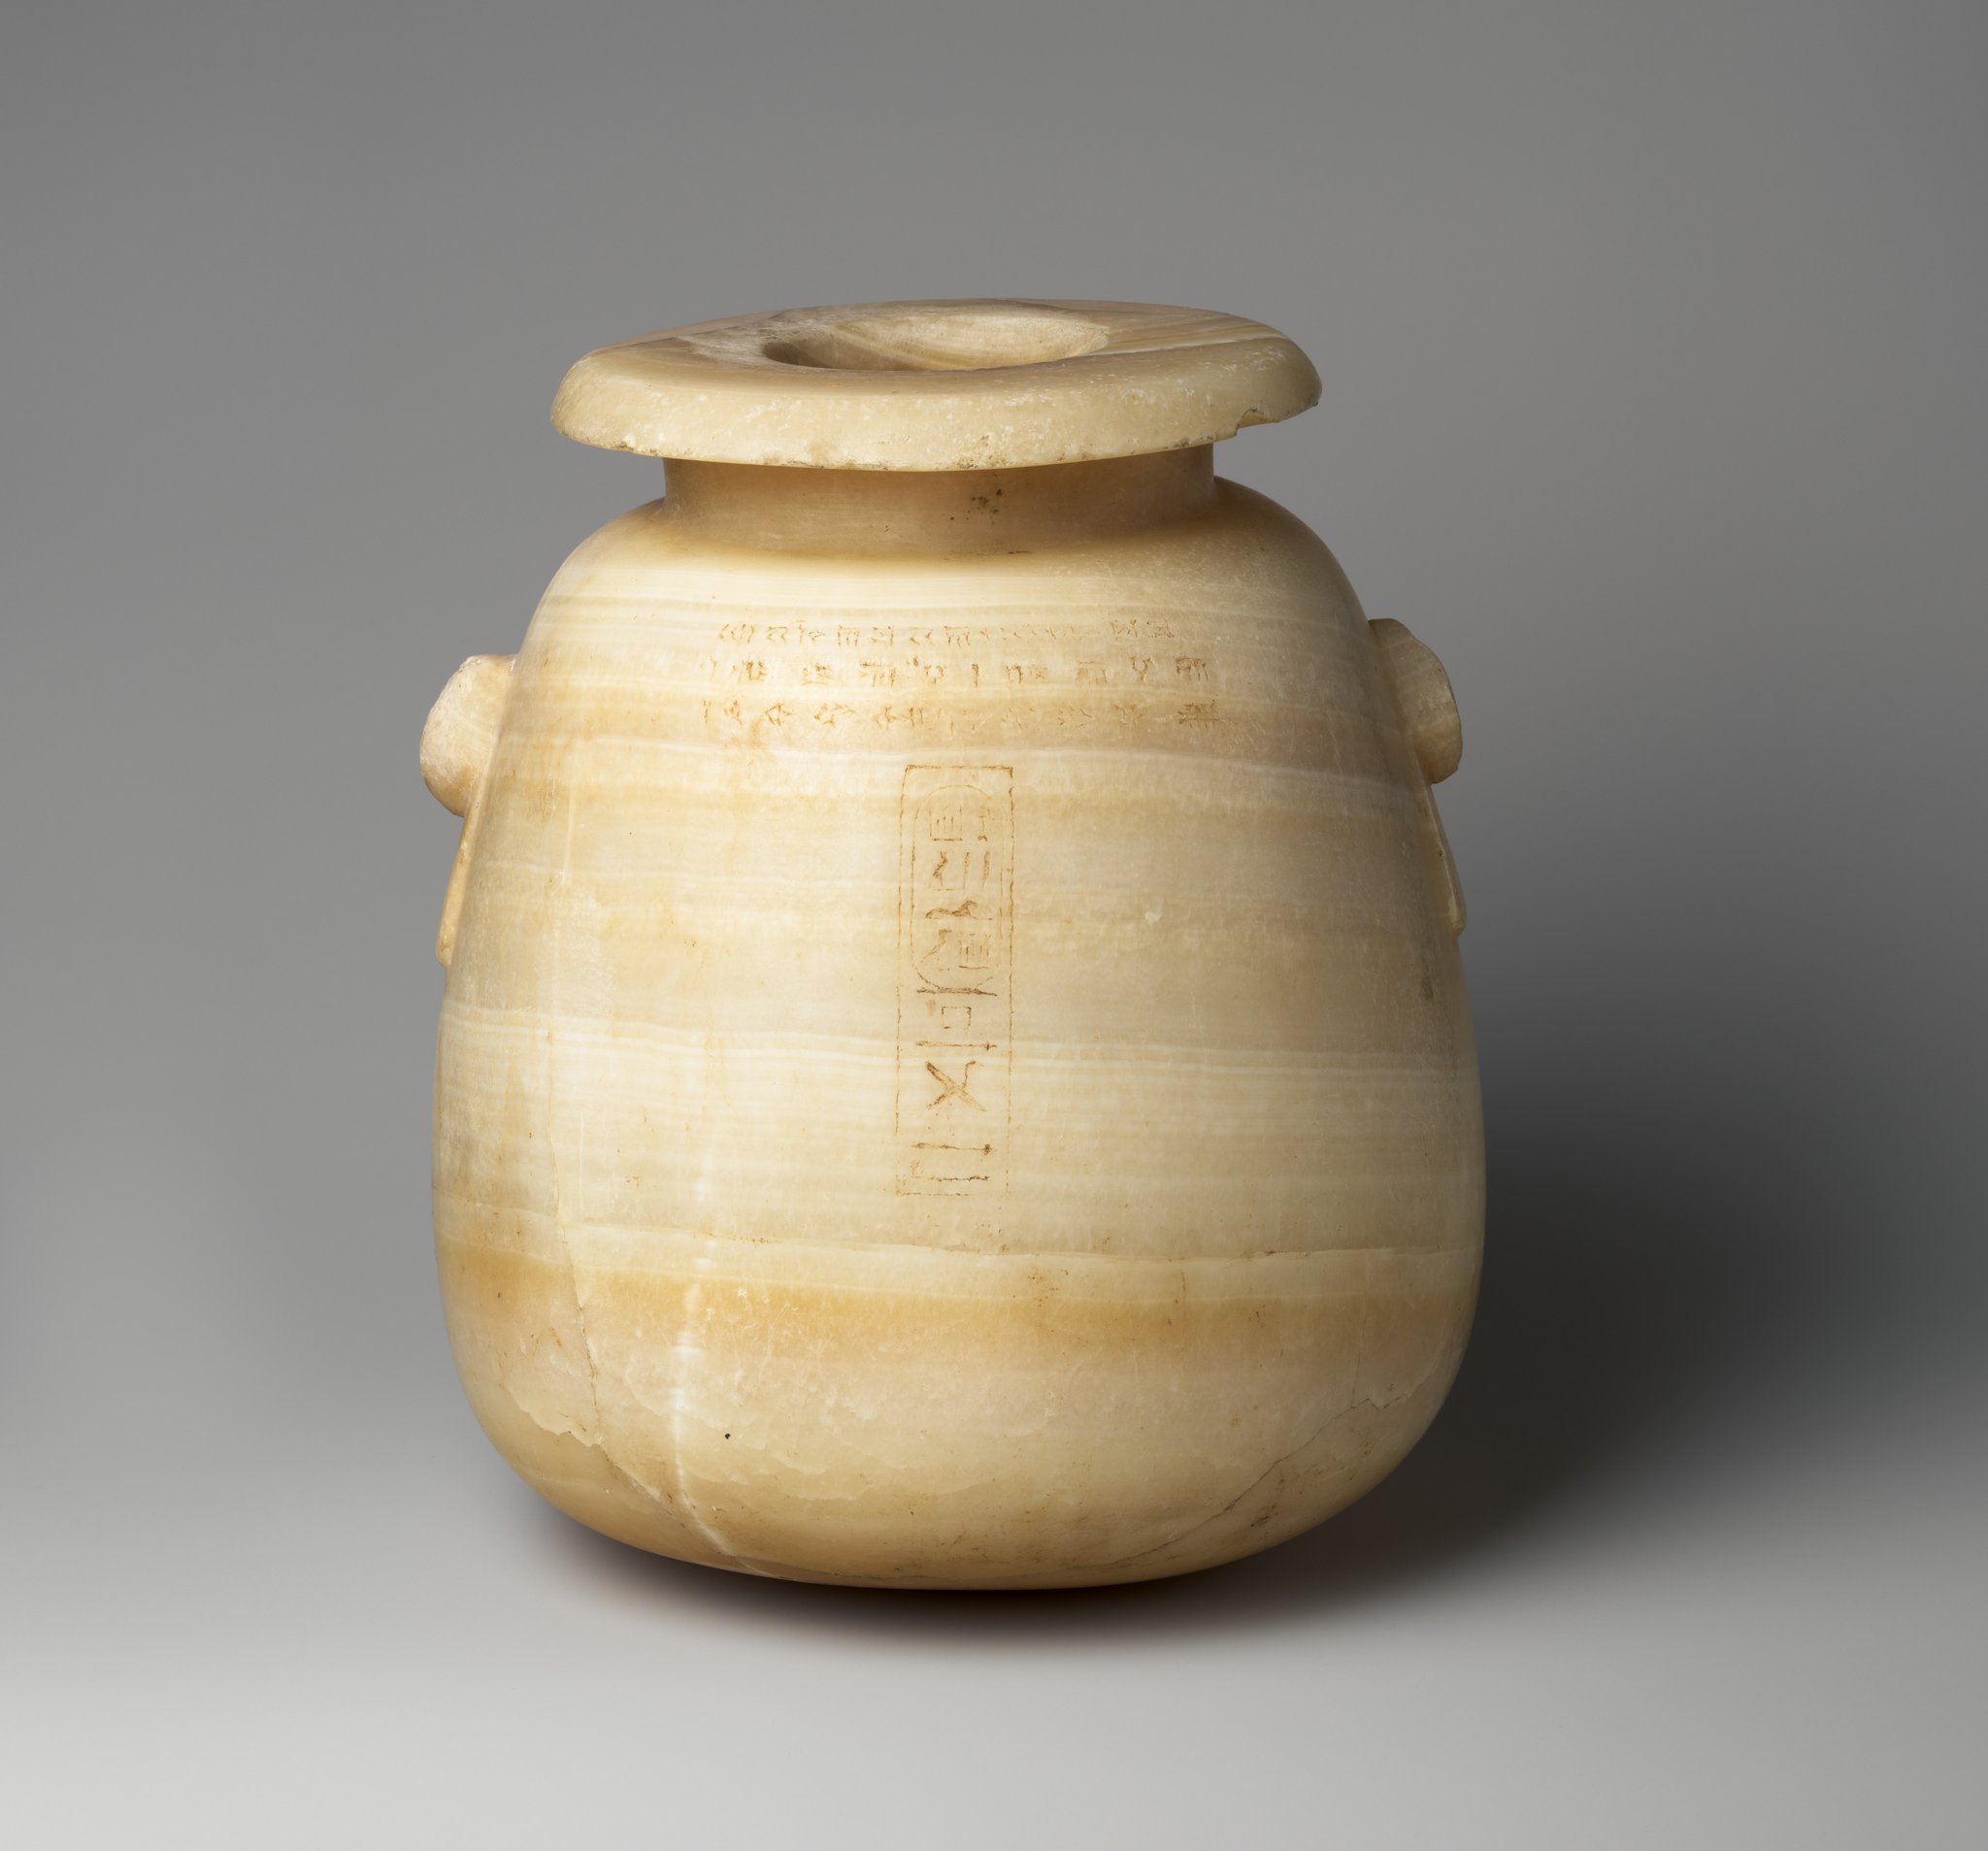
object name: jar, quadrilingual inscription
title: Jar with the name of Xerxes the Great in four languages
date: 485-465 BCE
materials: stone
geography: egypt